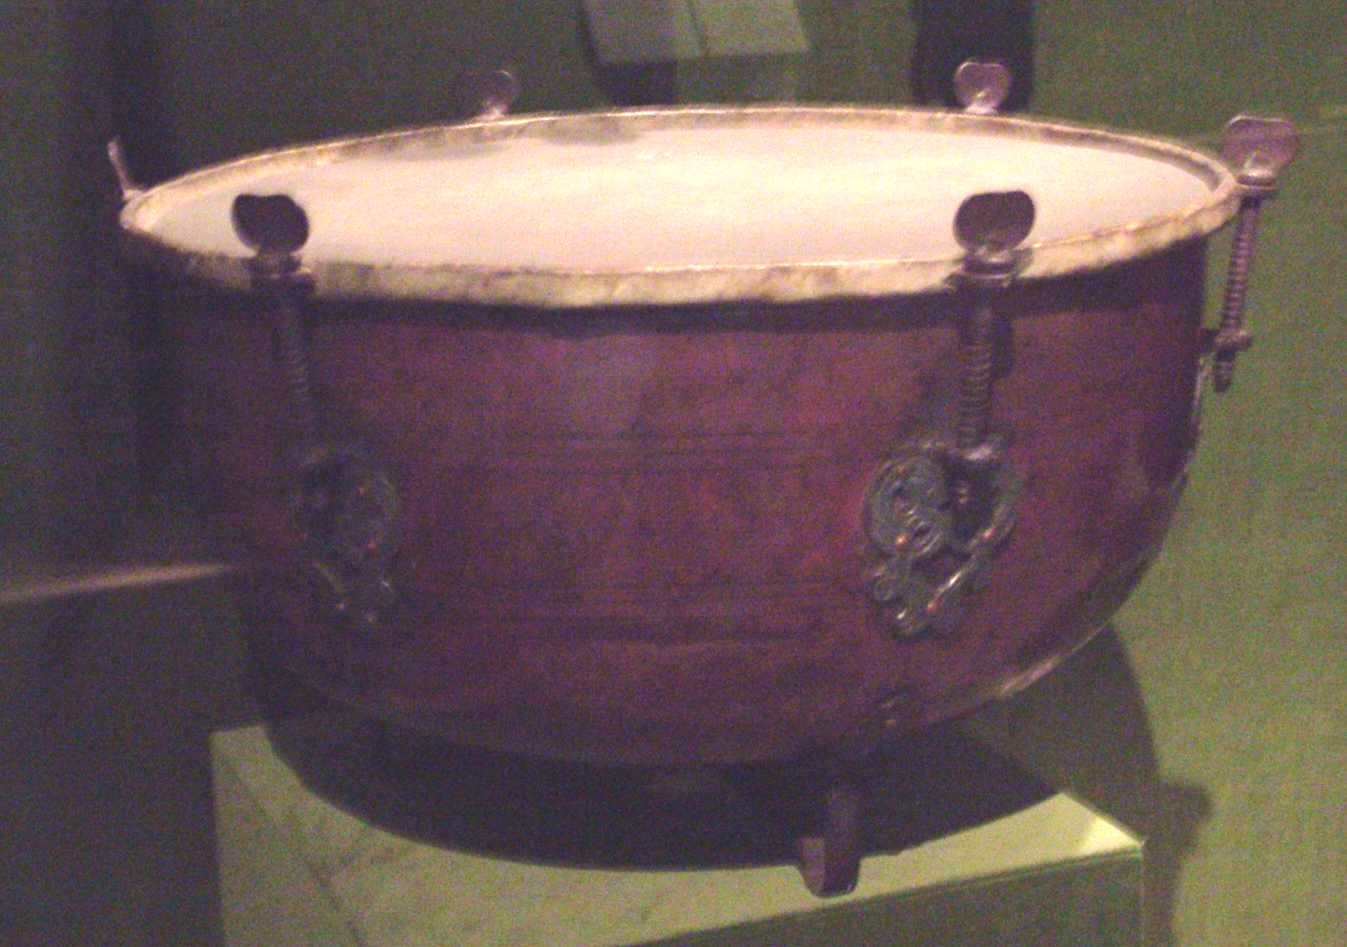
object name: kettledrum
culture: german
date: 1767-1800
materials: copper, iron, skin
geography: germany